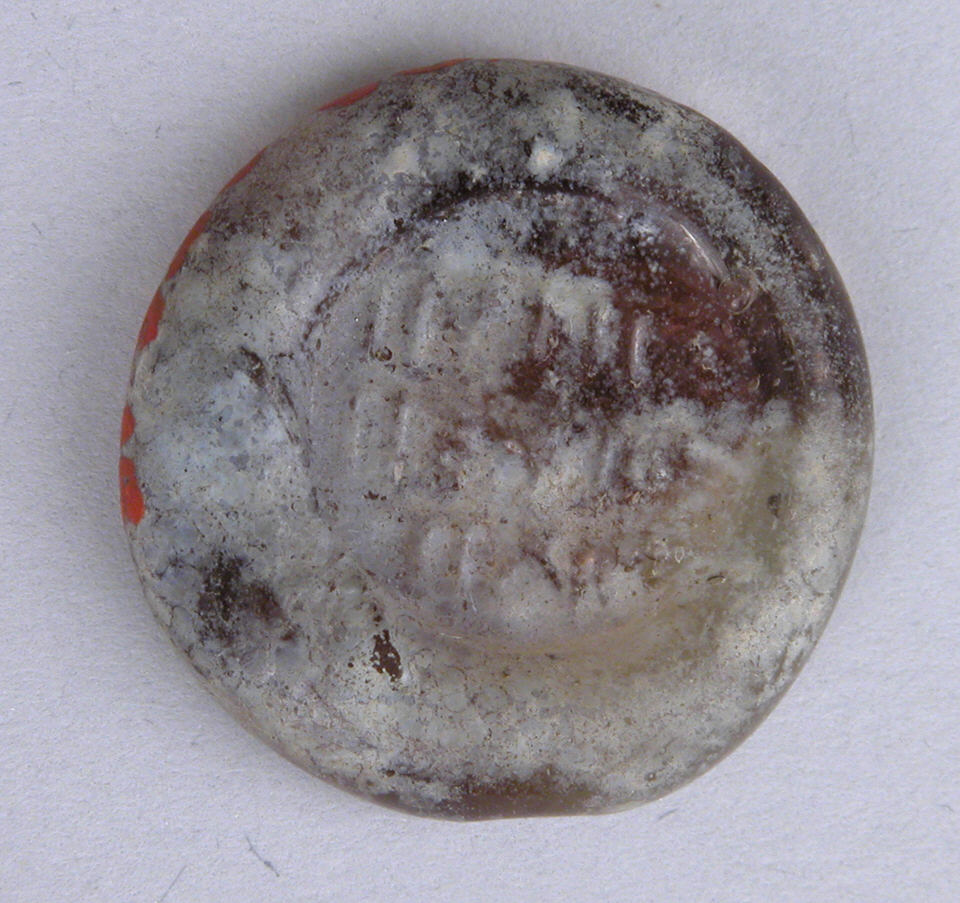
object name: coin weight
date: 1201-1400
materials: glass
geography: egypt